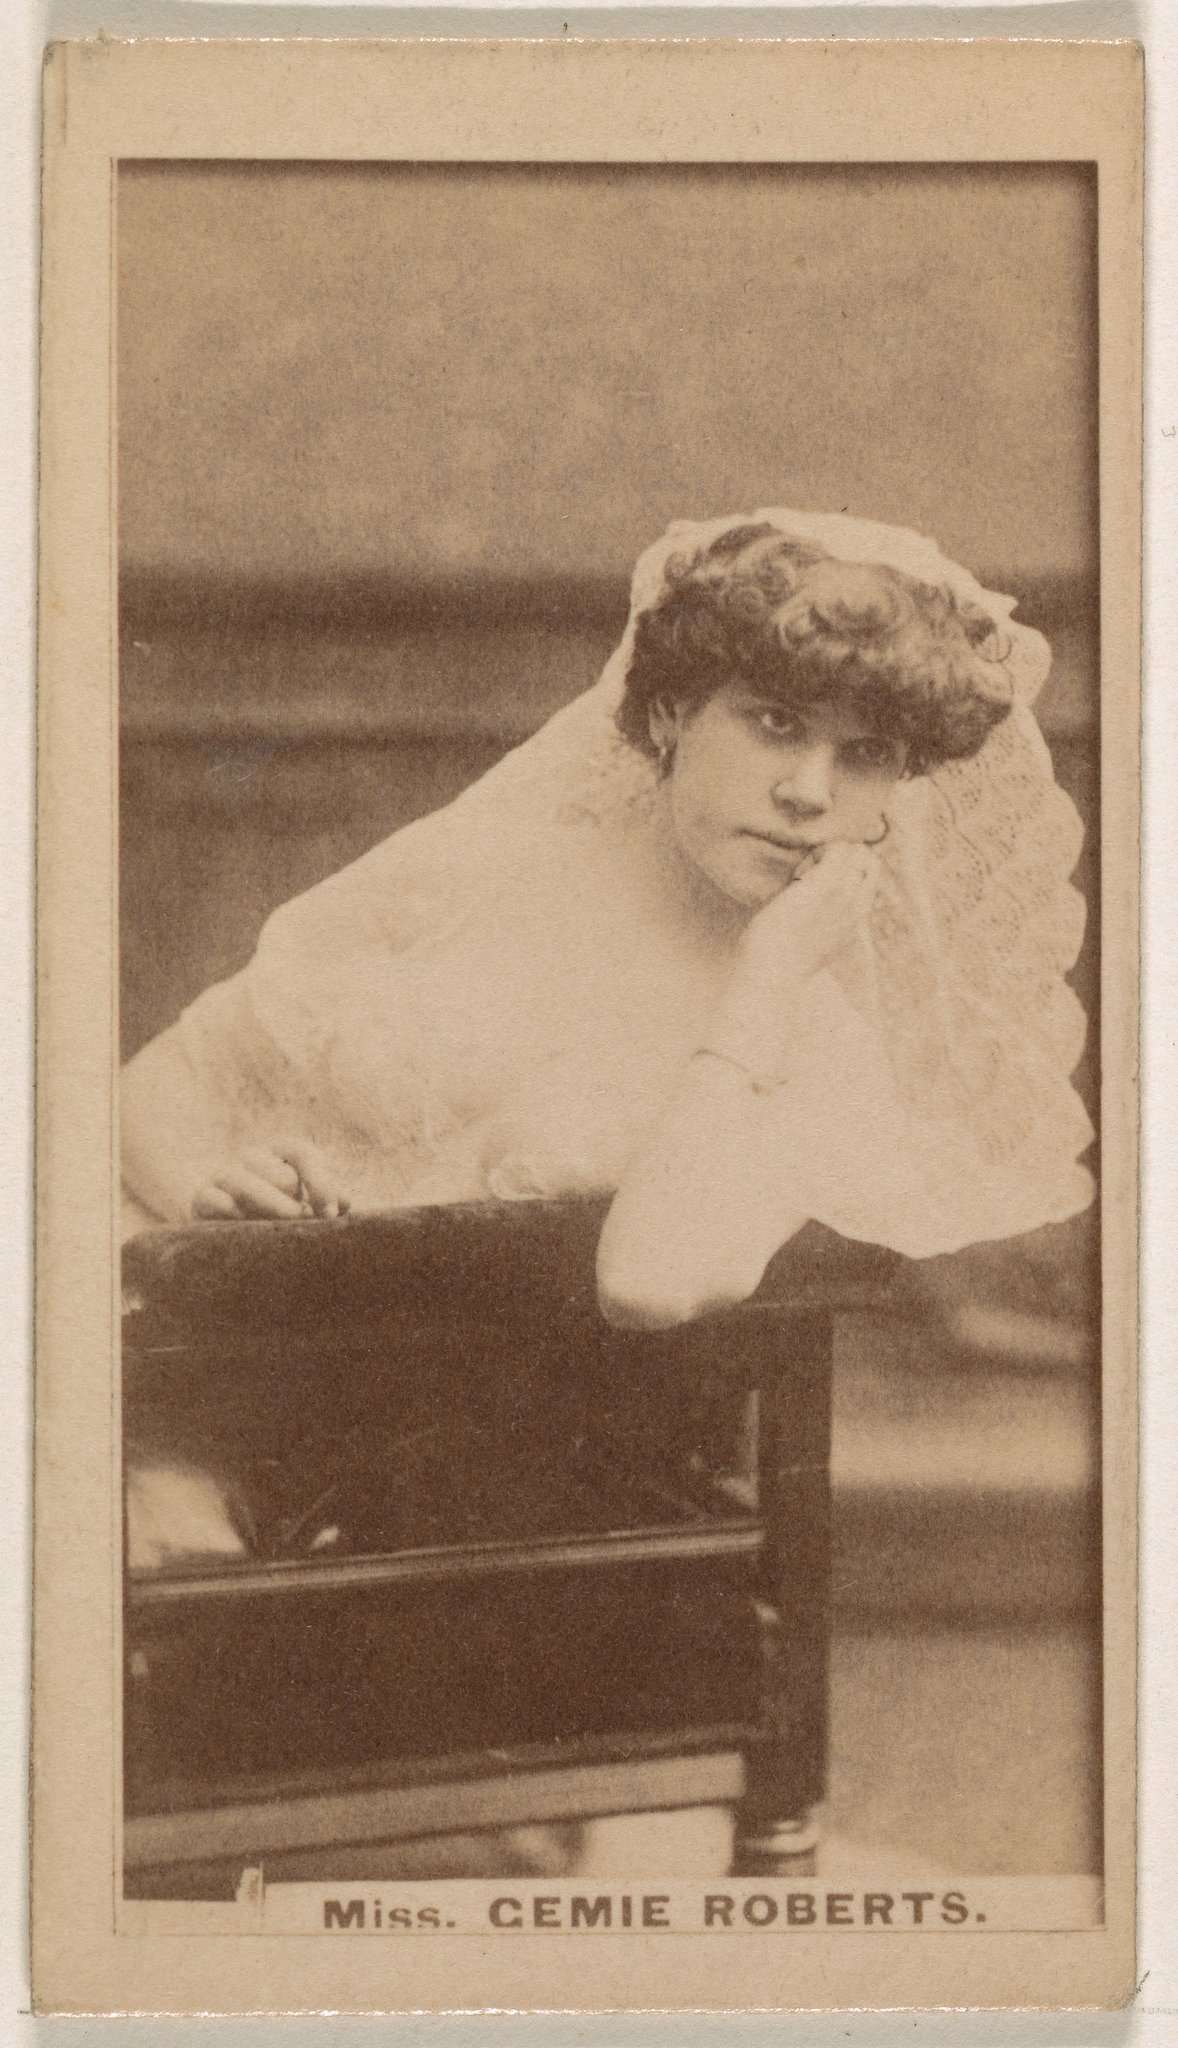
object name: photograph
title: Miss Cemie Roberts, from the Actresses series (N245) issued by Kinney Brothers to promote Sweet Caporal Cigarettes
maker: kinney brothers tobacco company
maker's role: publisher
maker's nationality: american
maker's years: 1869-2011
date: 1890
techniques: albumen silver print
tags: portraits,women,actresses